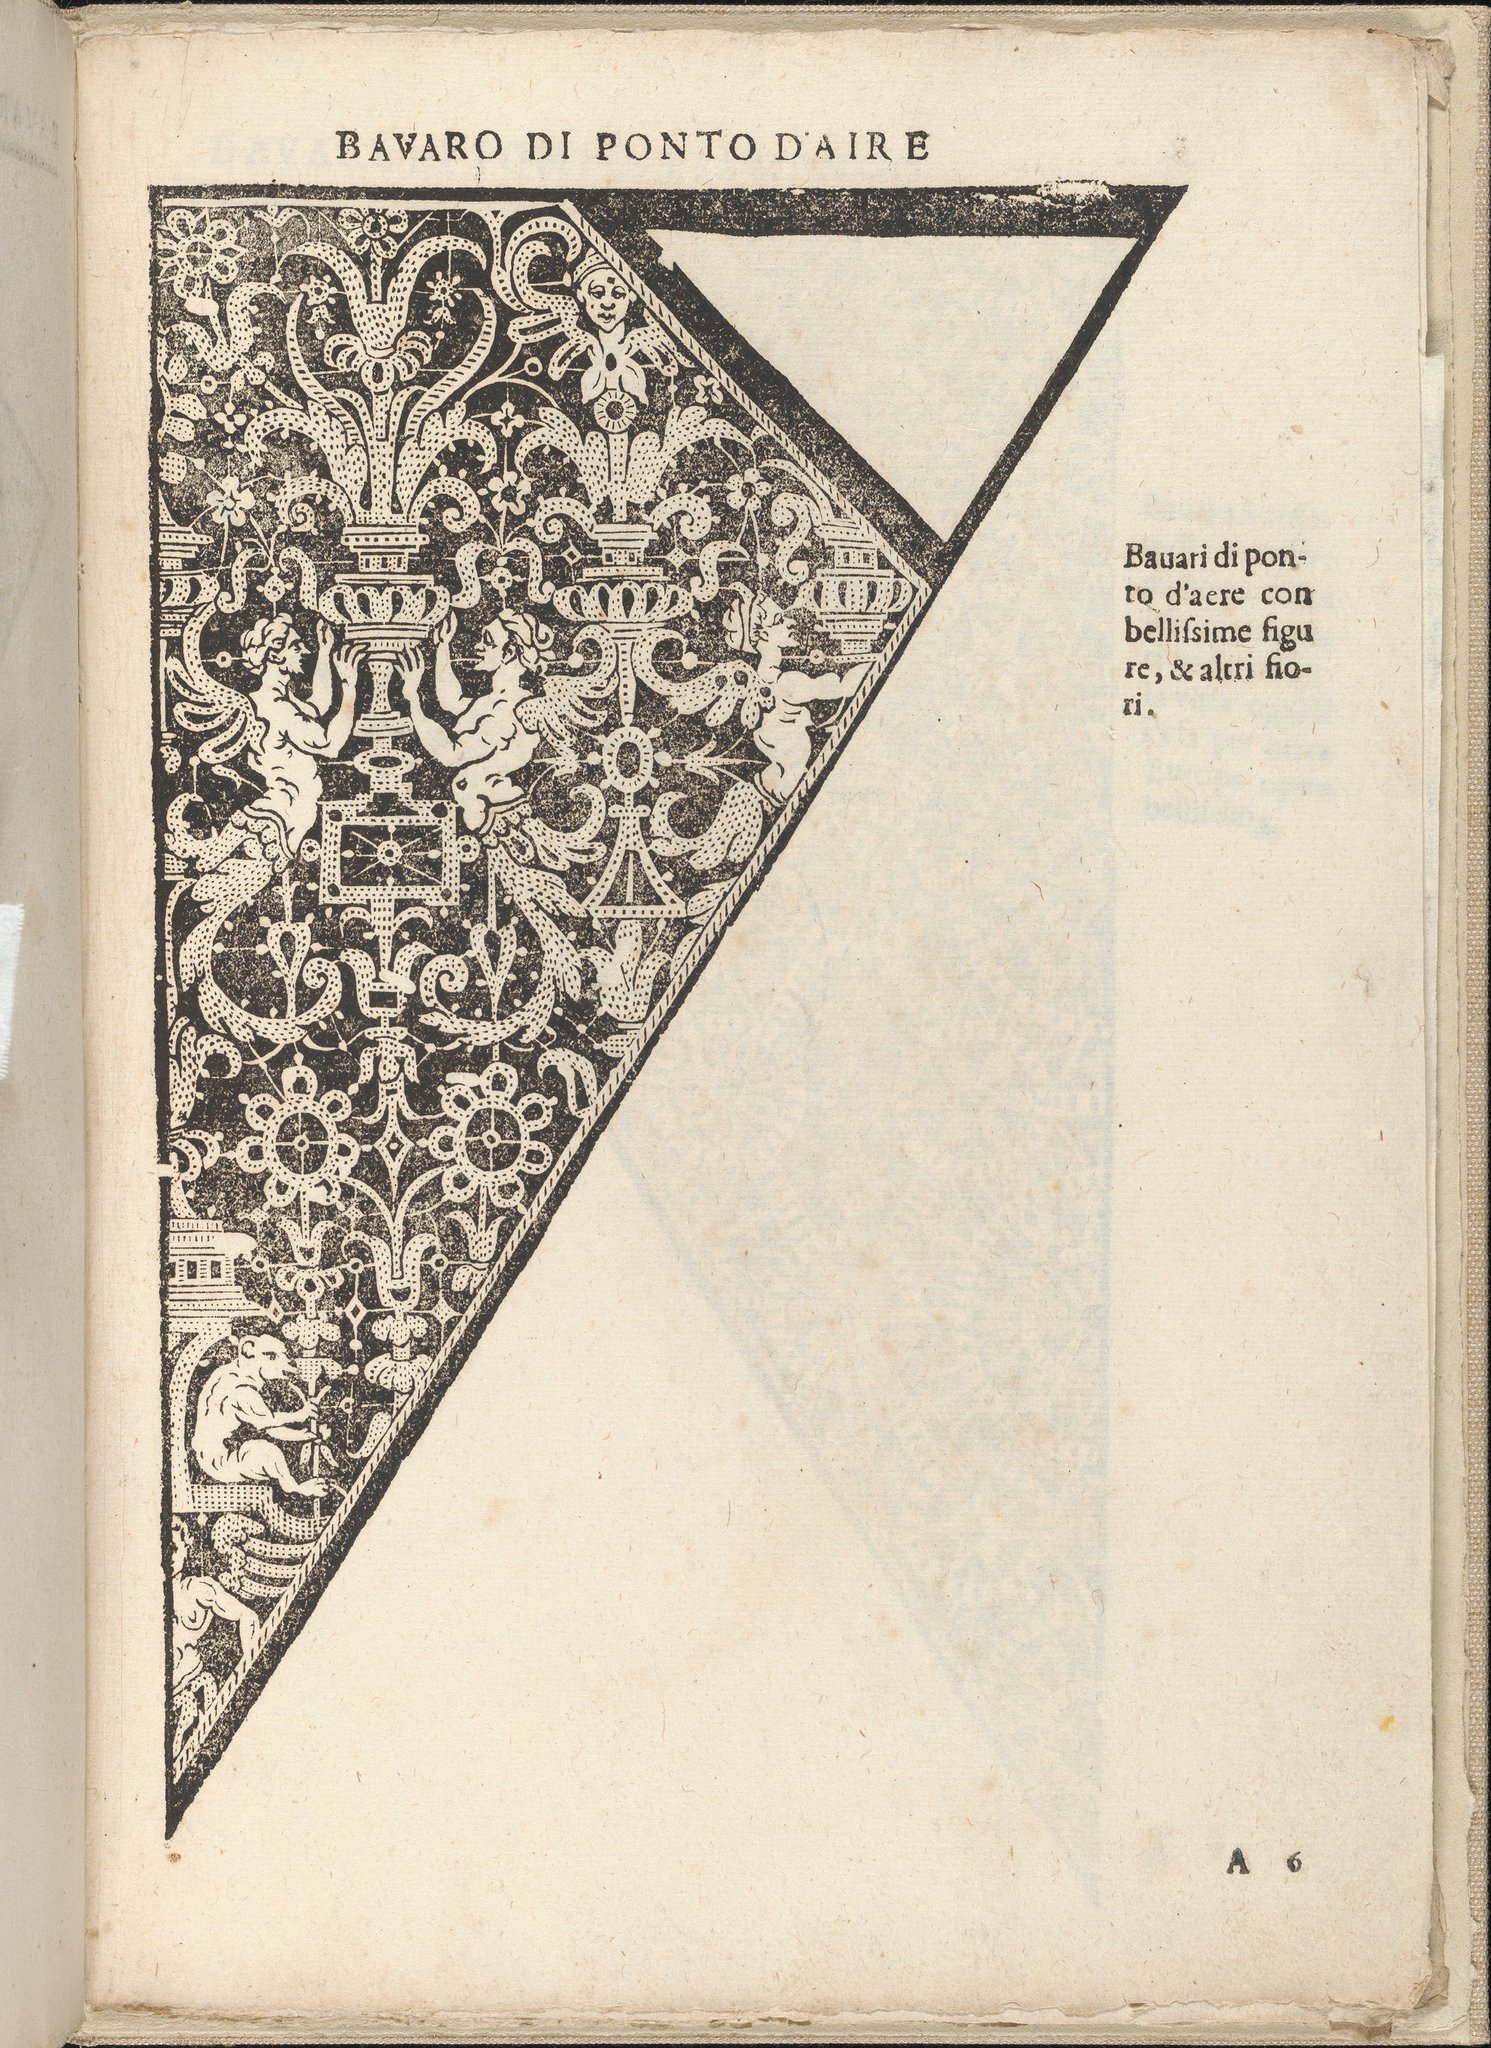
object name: book print ornament architecture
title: Ornamento nobile...Fatta da Lucretia Romana (Libro V of the Corona), page 6 (recto)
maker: cesare vecellio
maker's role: author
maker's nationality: italian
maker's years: 1521-1601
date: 1620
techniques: woodcut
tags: ornament